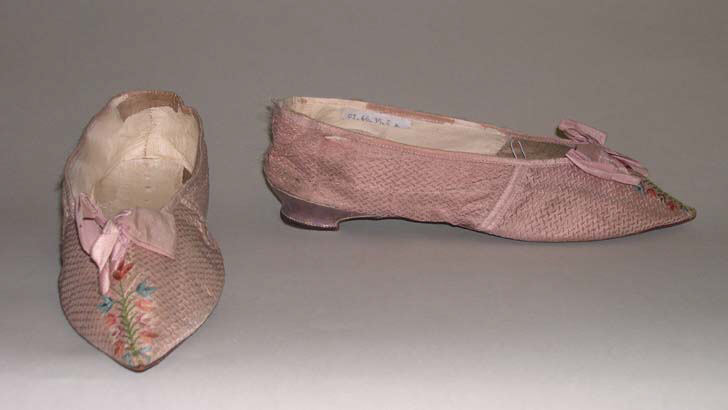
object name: slipper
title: Slippers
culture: british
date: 1790-1799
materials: leather, silk